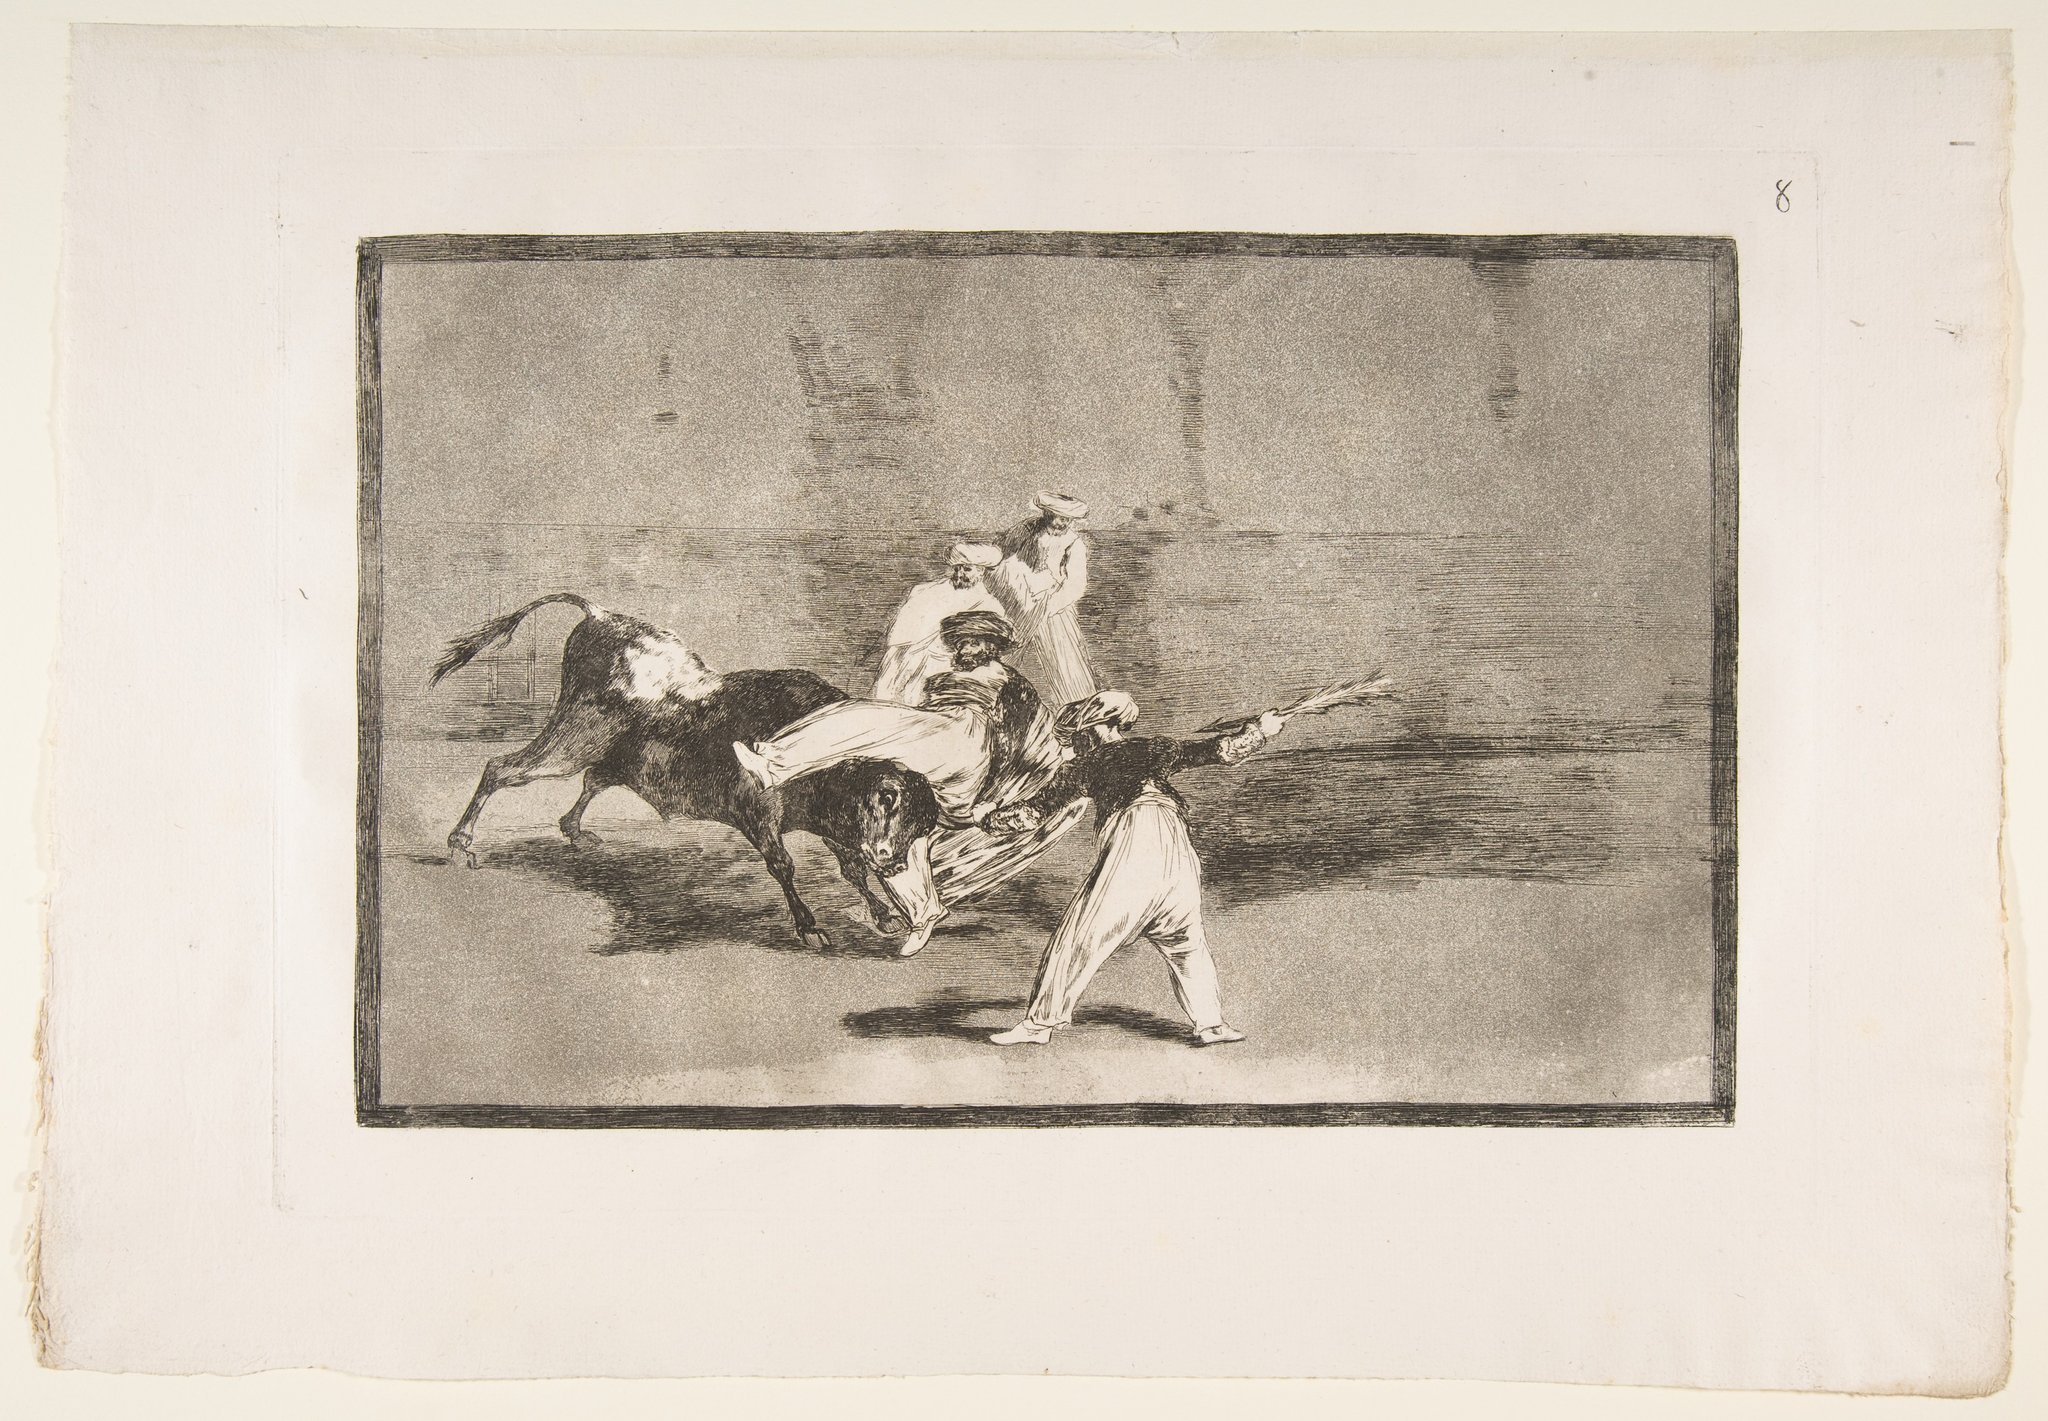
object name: print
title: Plate 8 from "La Tauromaquia": A Moor caught by the bull in the ring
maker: goya (francisco de goya y lucientes)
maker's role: artist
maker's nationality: spanish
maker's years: 1746-1828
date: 1816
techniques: aquatint, burnishing, drypoint, etching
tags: men,bulls